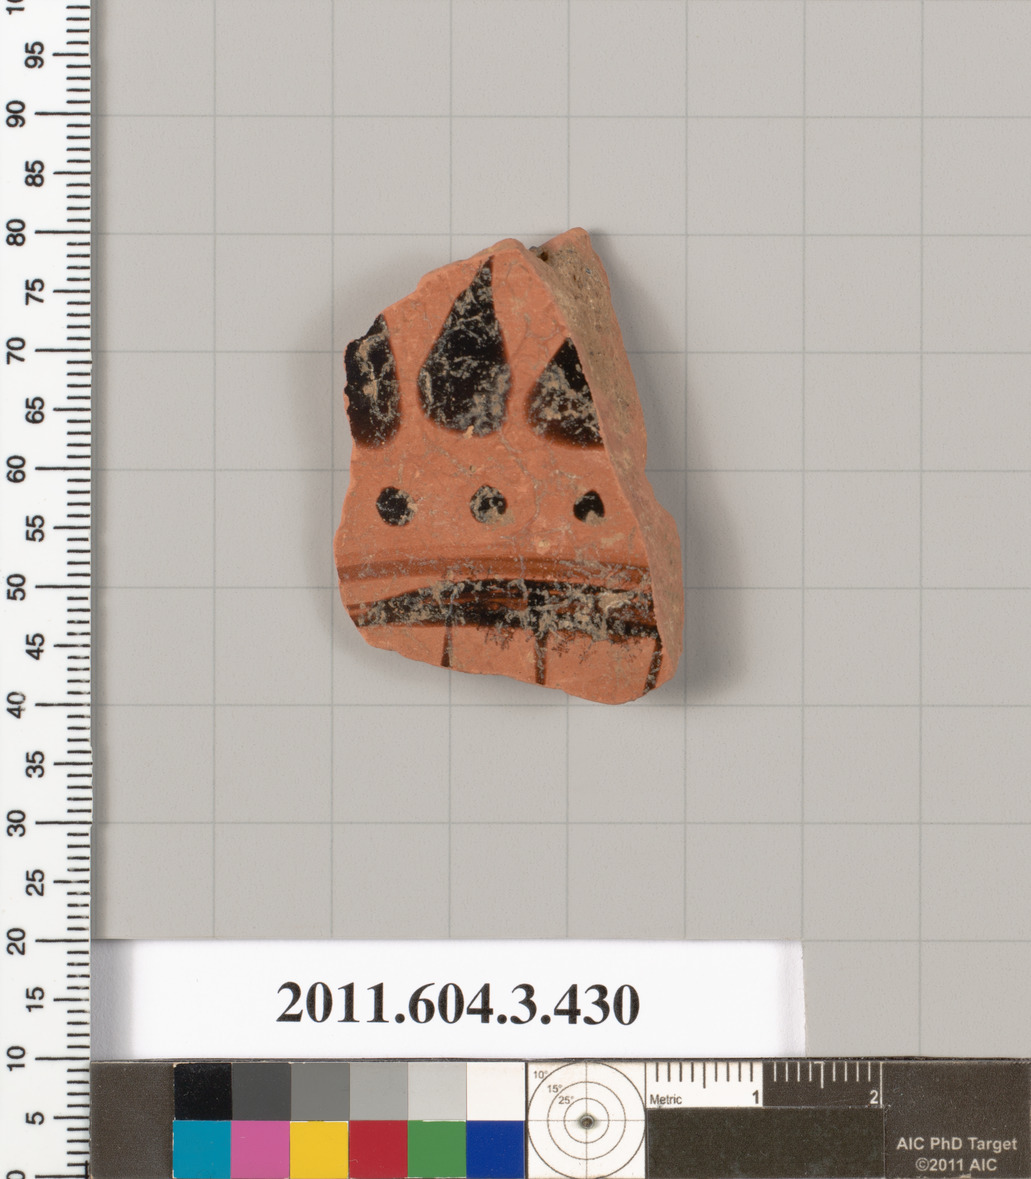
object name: neck amphora fragment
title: Terracotta fragment of a neck-amphora (jar)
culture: greek, attic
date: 534-468 BCE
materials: terracotta